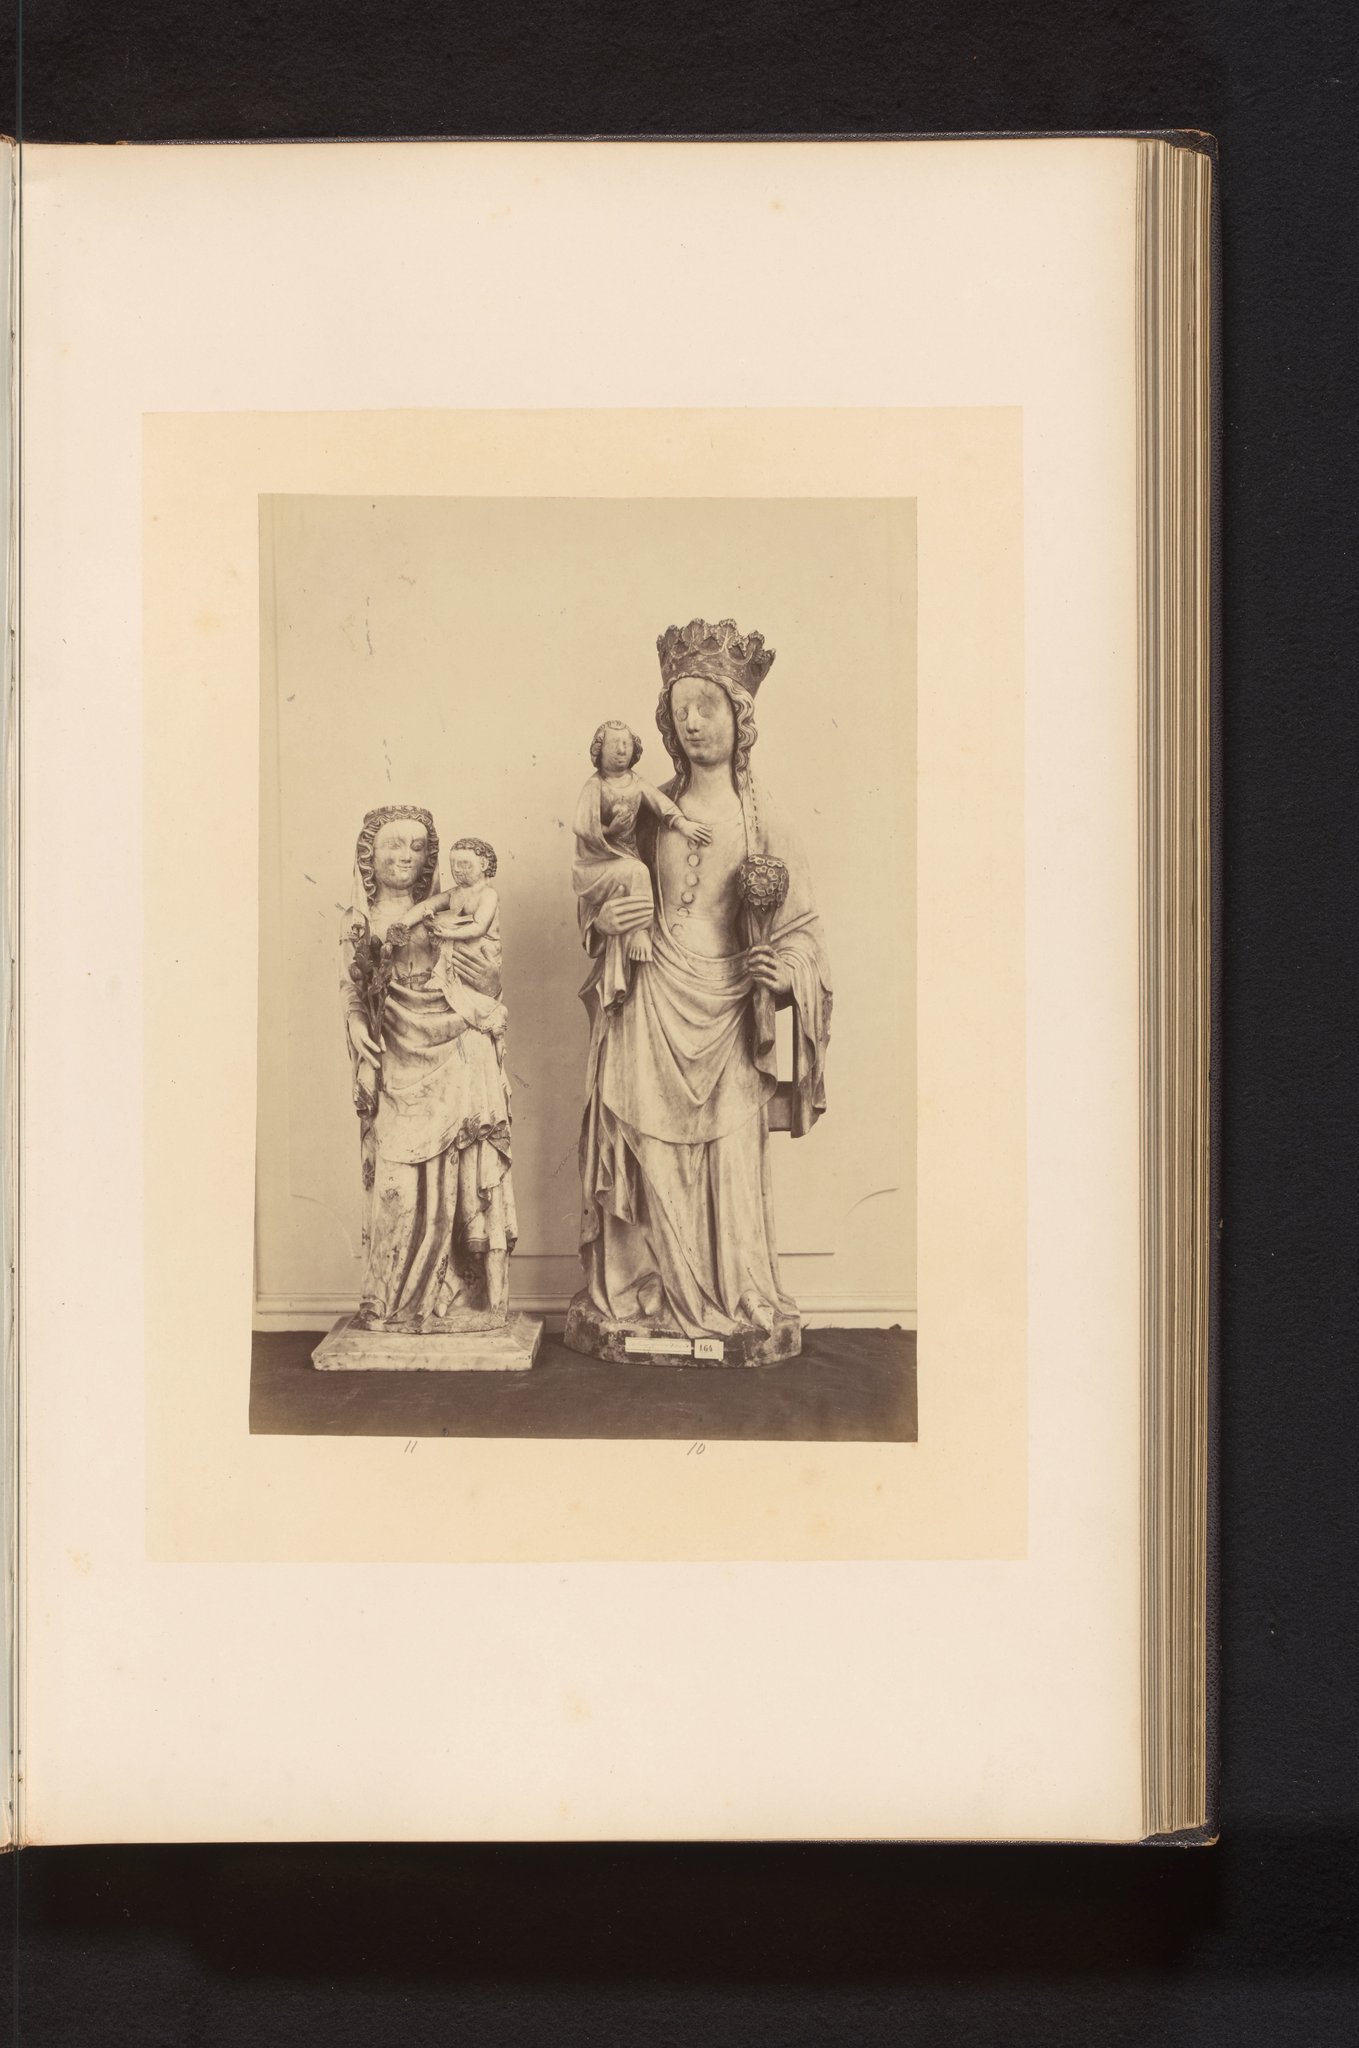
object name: photograph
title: Sculptuur van albast en een sculptuur van marmer van Maria met kind, opgesteld op een tentoonstelling over religieuze objecten uit de middeleeuwen en renaissance in 1864 in Mechelen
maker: joseph maes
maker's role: fotograaf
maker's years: 1838-1908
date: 1864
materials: photographic support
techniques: albumen print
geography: mechelen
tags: mary standing (or half-length), the christ-child sitting on her arm (christ-child to mary's left), piece of sculpture, reproduction of a piece of sculpture (+ stone ~ arts), mechelen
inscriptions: number: ‘11 - 10’